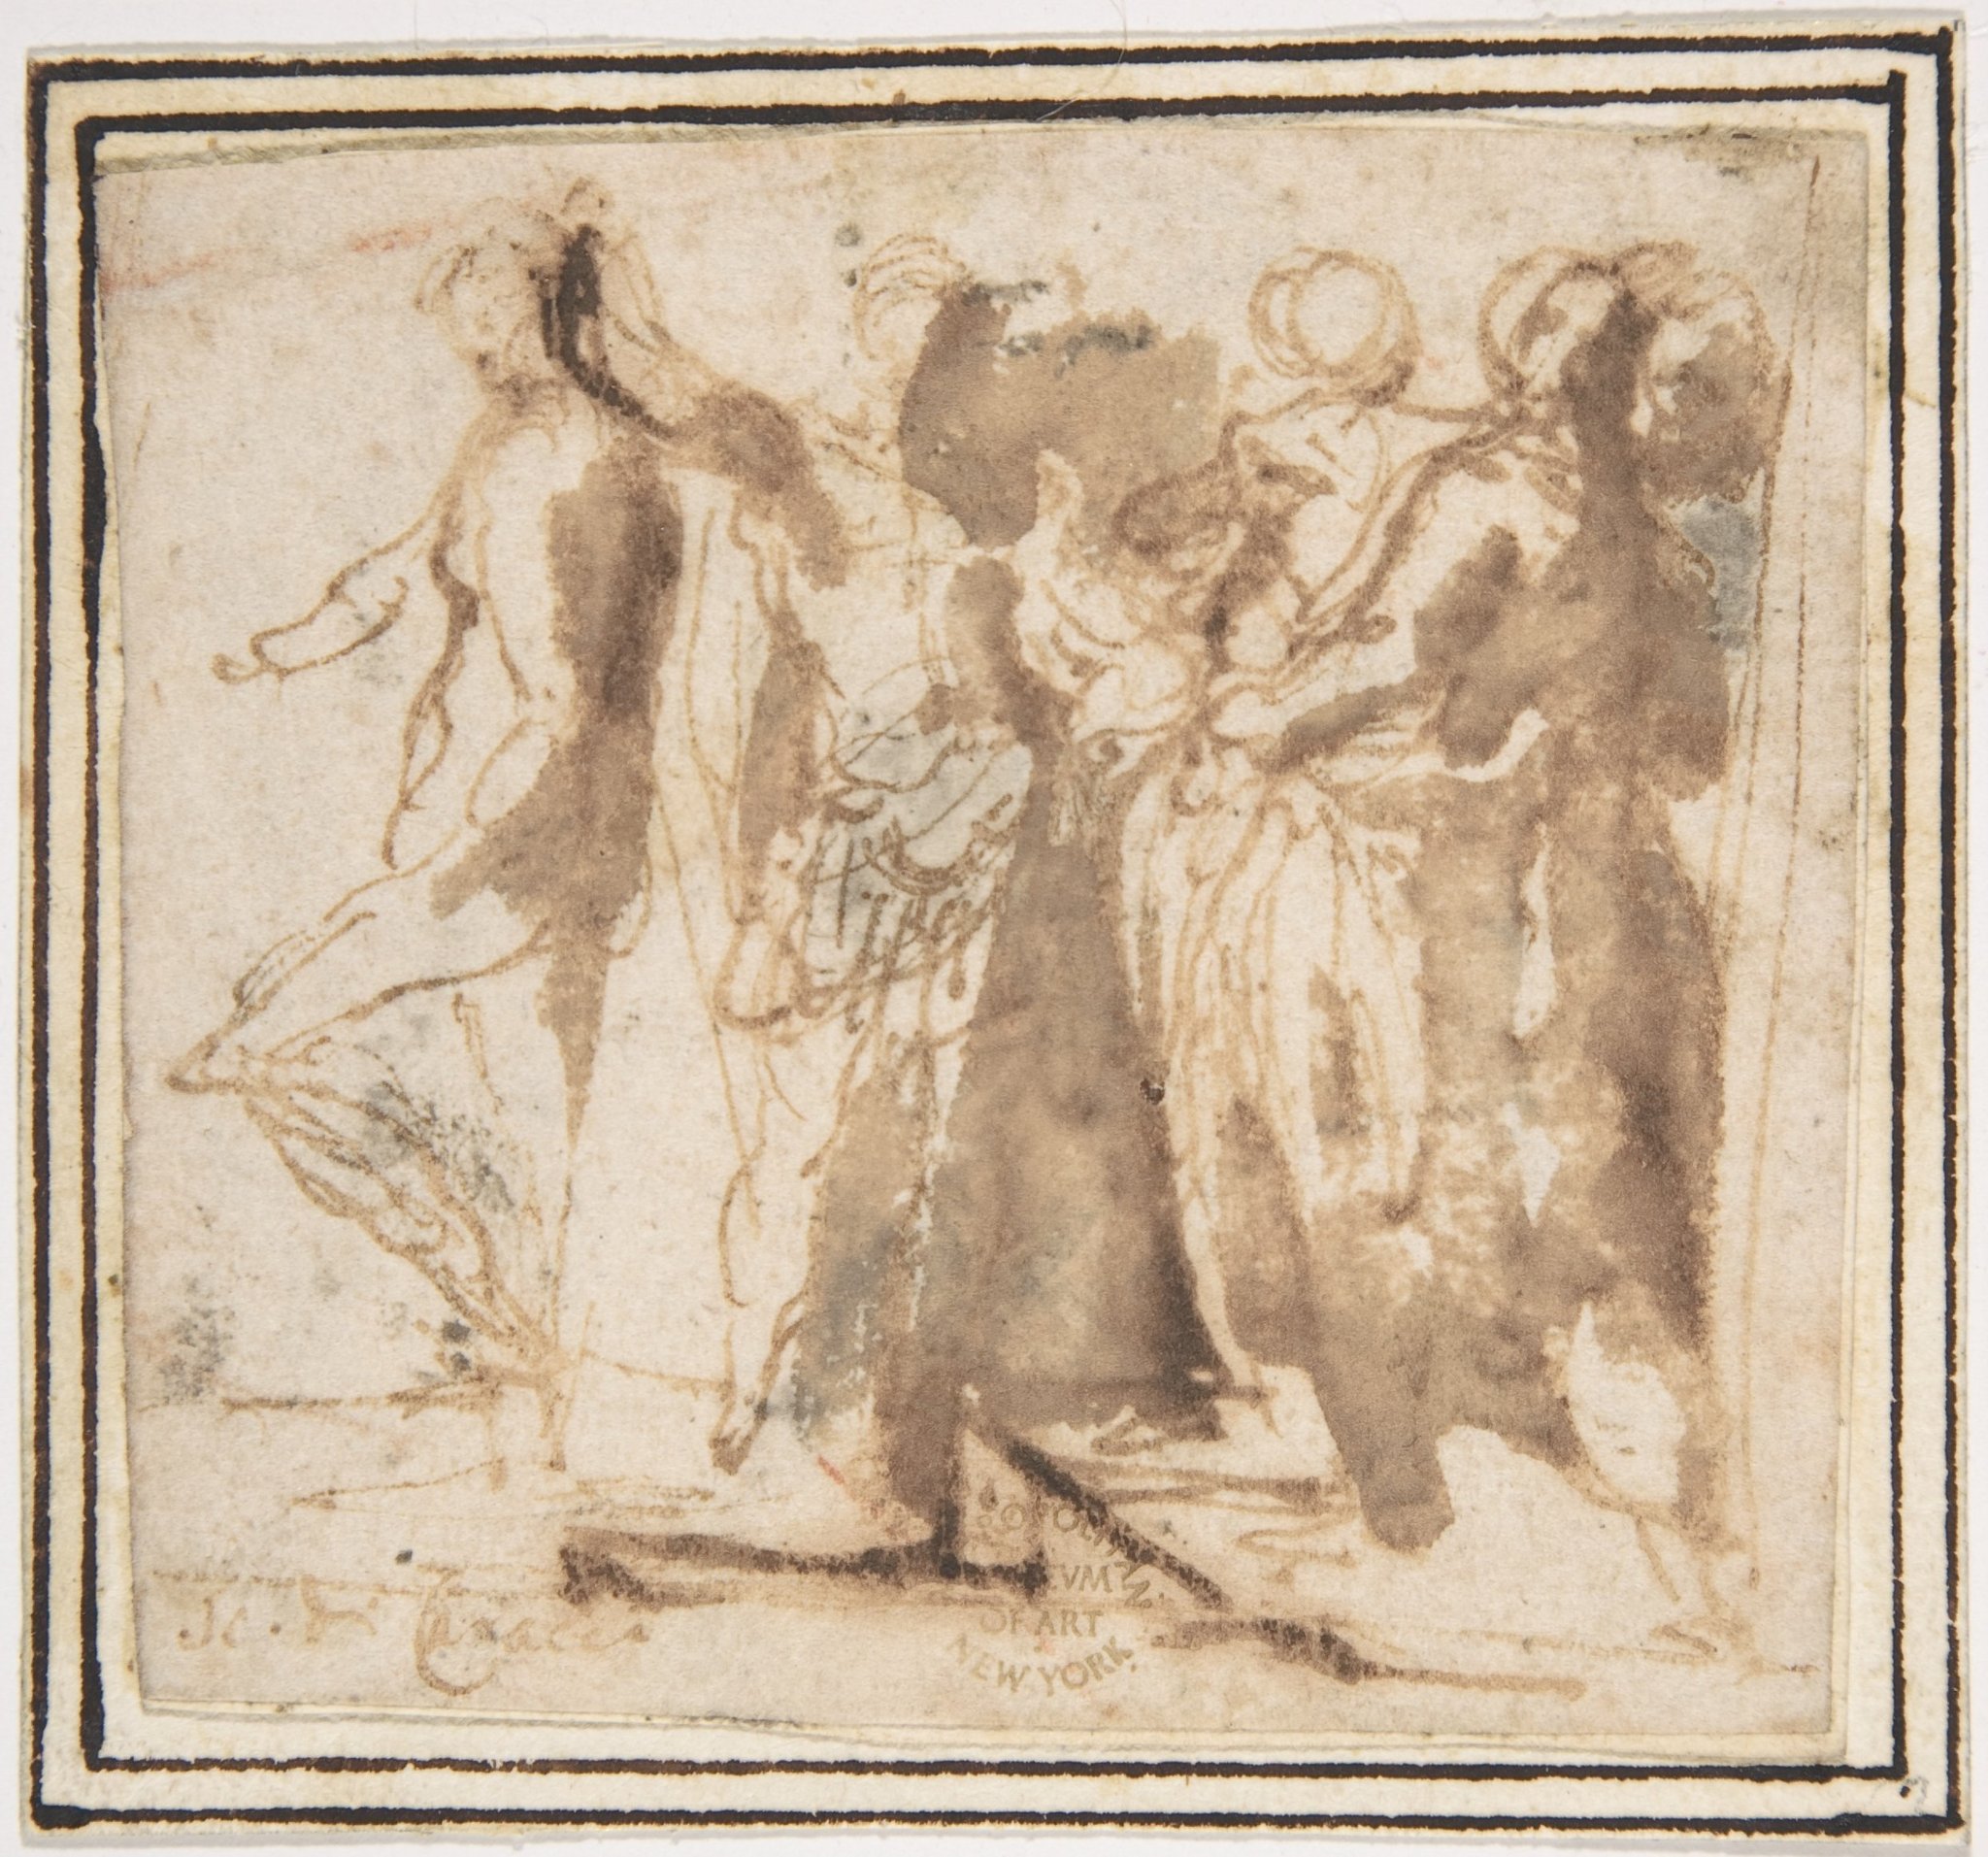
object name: drawing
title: Figures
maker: francesco allegrini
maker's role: artist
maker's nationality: italian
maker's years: 1615-1679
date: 1624-1663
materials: ink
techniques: brush, pen, wash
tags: human figures